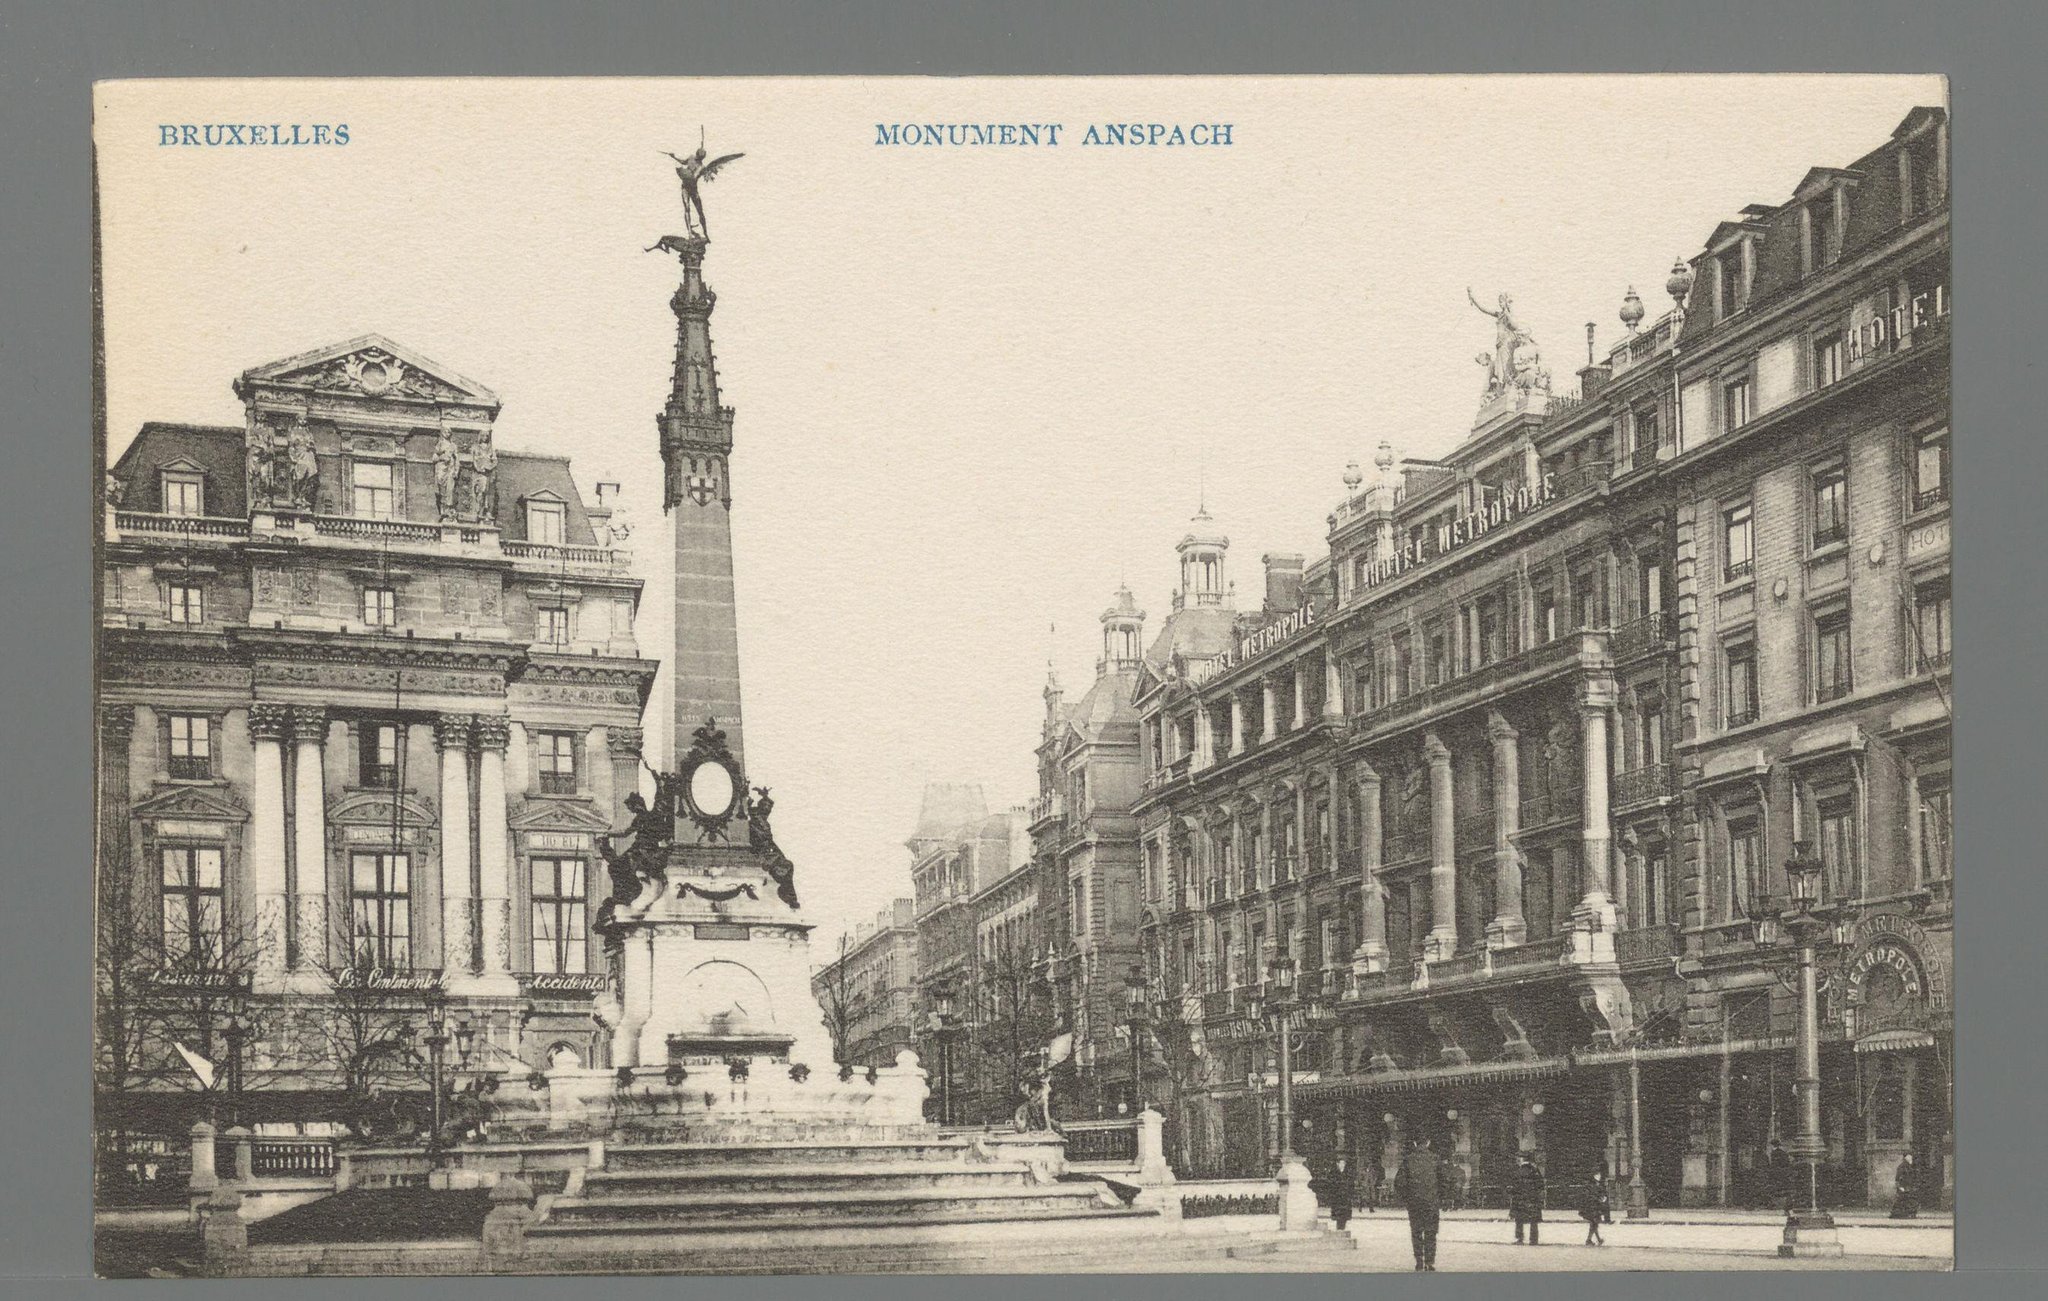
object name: ansichtkaart, prentbriefkaart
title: Bruxelles. Monument Anspach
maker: Anonymous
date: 1906-1930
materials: cardboard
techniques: photograph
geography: brussels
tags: monument, statue, city-view, and landscape with man-made constructions (+ city(-scape) with figures, staffage)